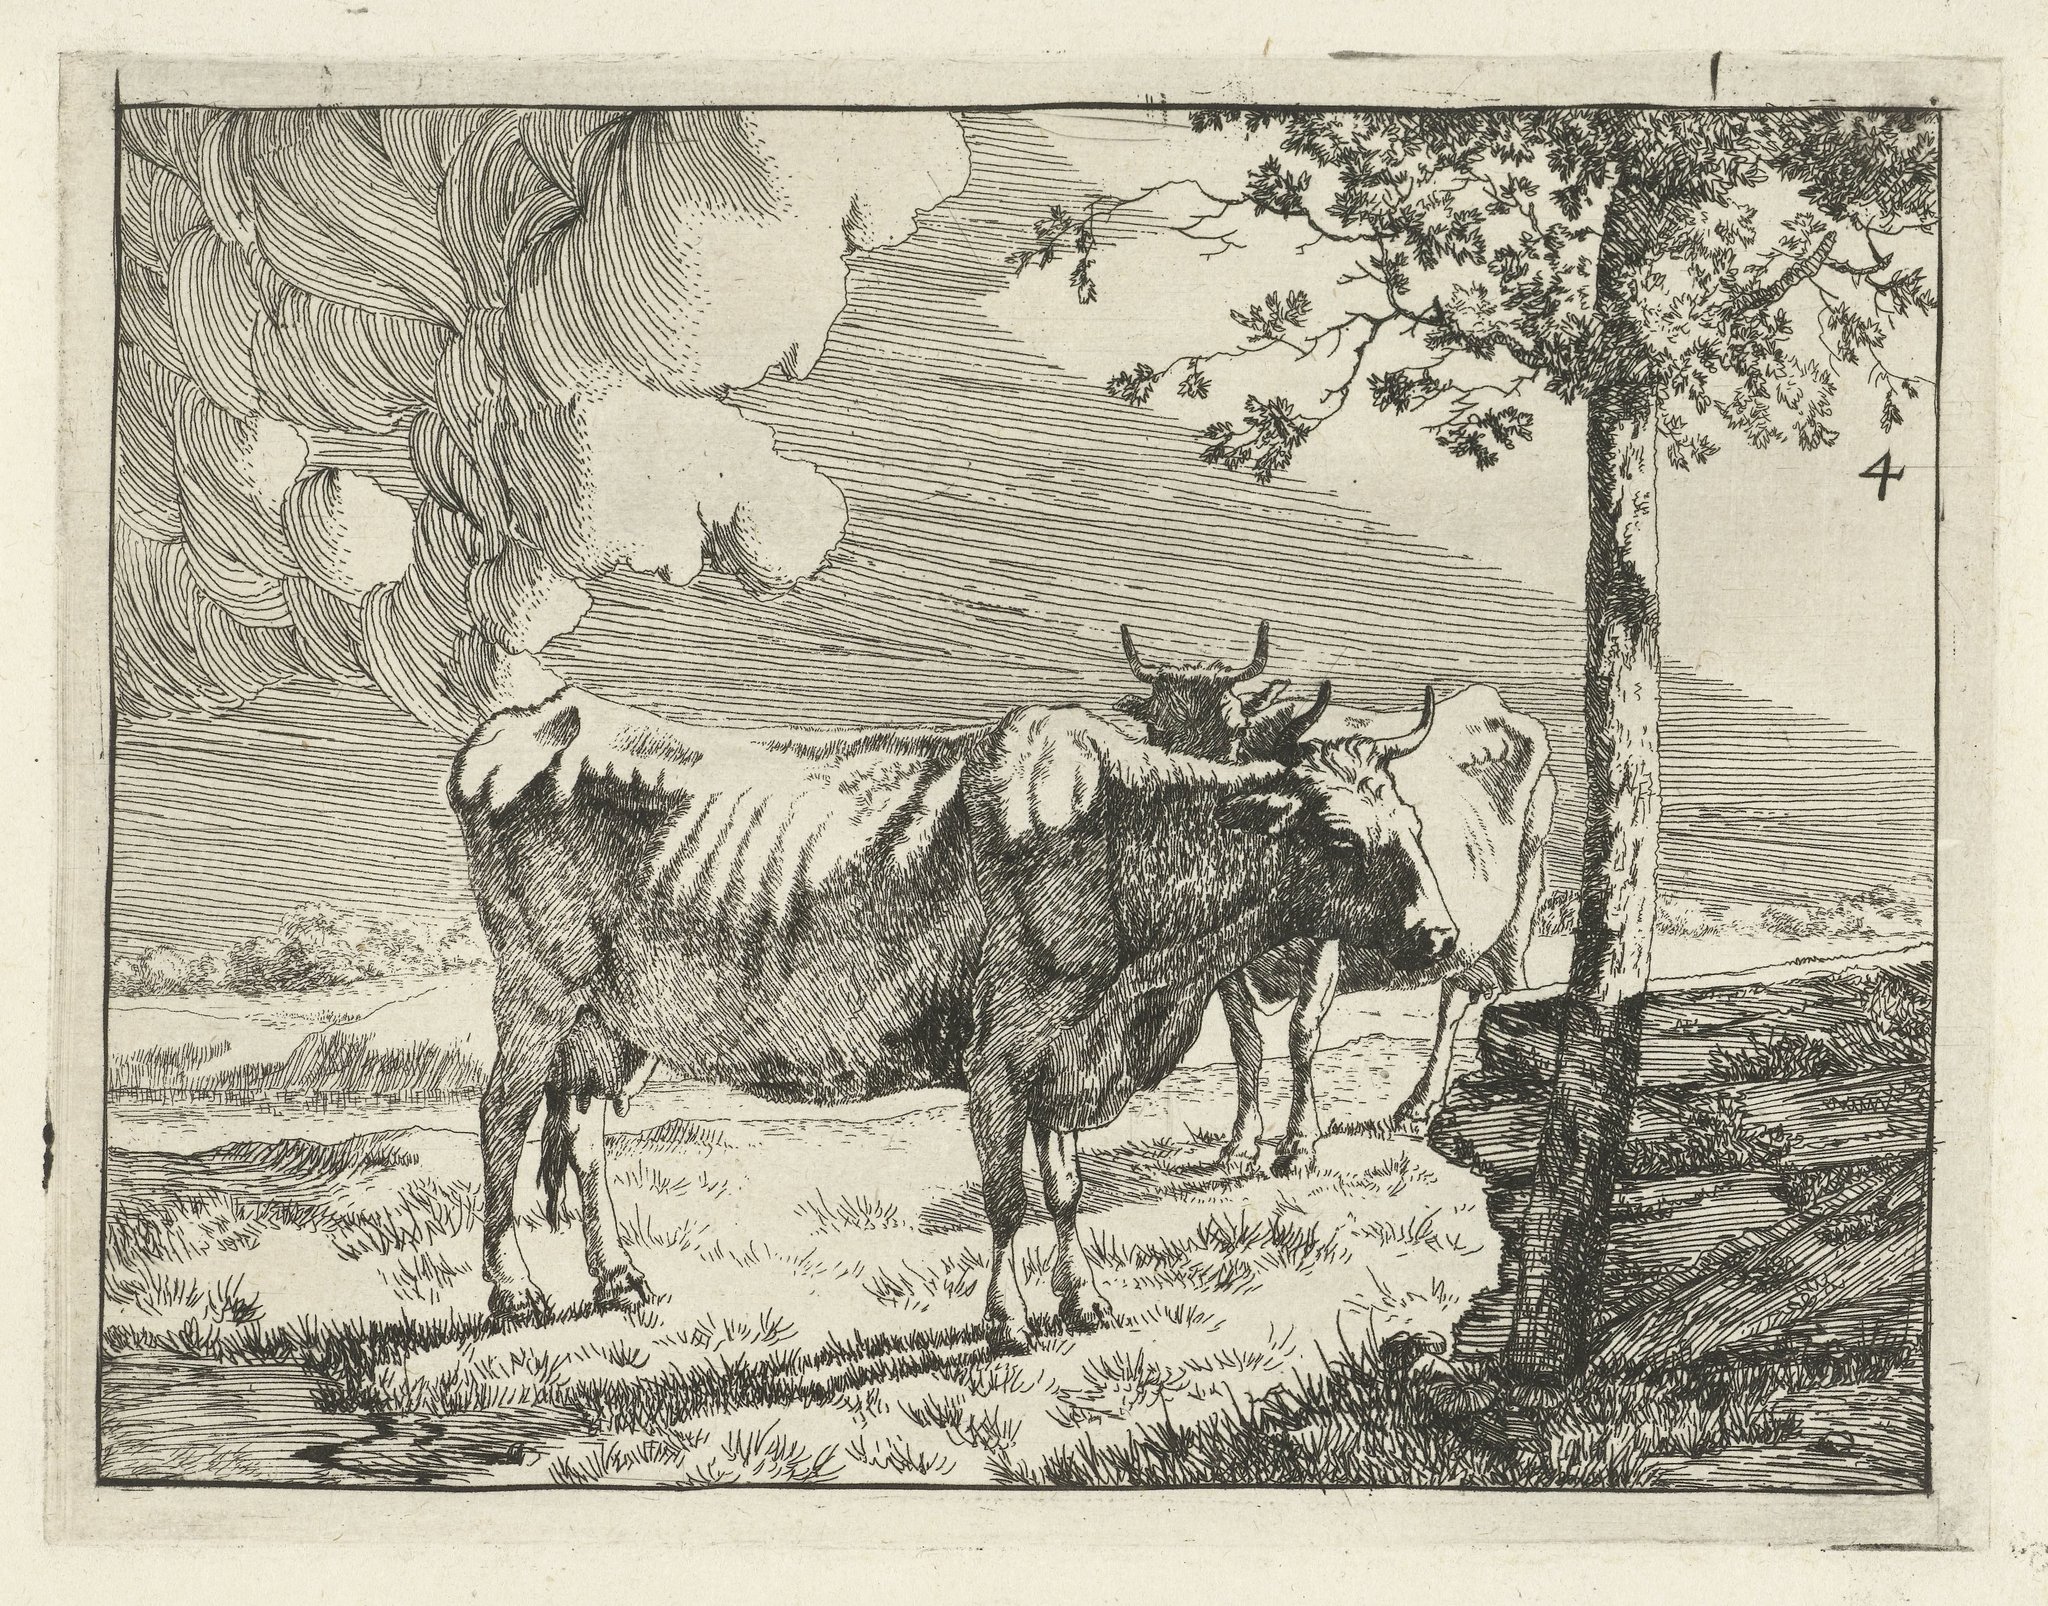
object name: print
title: Koeien en stieren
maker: marcus de bye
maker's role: print maker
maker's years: 1639-1688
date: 1657-1677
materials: paper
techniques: etching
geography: the hague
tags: cow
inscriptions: collector's mark: Lugt 240